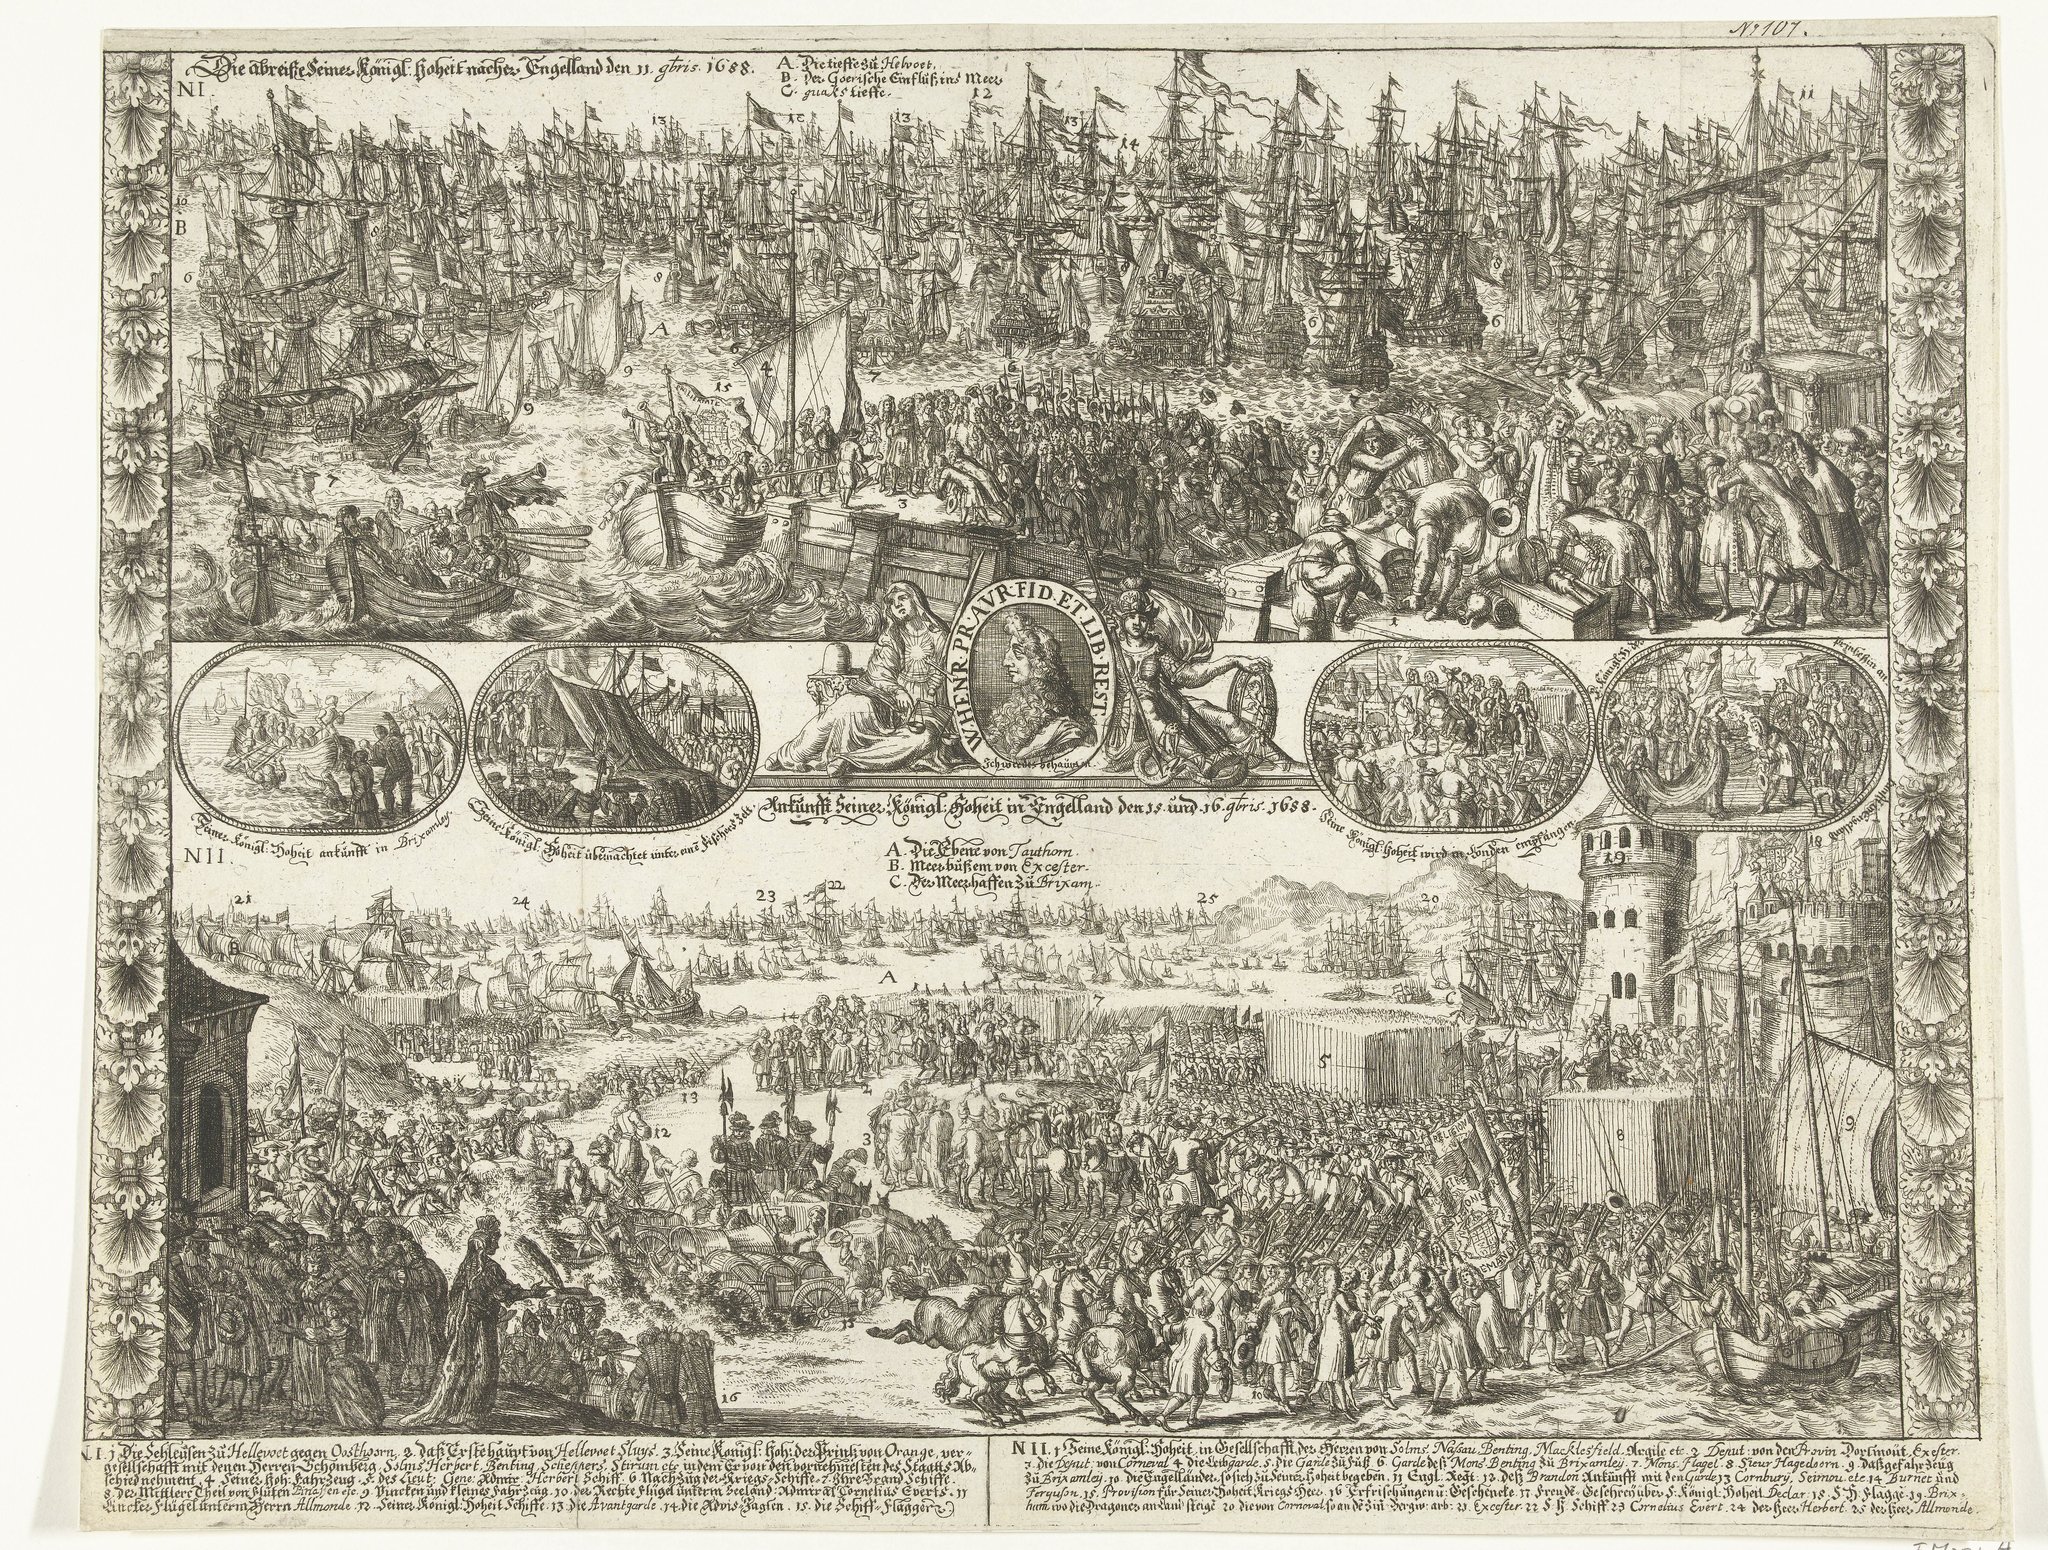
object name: print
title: Die abreisse Seiner Königl: Hoheit nacher Engelland den 11. [novem]bris 1688 / Ankunfft Seiner Königl: Hoheit in Engelland den 15. und 16. [novem]bris 1688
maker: Anonymous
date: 1688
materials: paper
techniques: etching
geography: northern netherlands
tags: the hague, william iii (prince of orange and king of england, scotland, and ireland), arrival and return ~ travelling, departure ~ travelling, hellevoetsluis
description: Tocht van Willem III naar Engeland, 1688. Twee voorstellingen, genummerd I en II. Boven: het vertek van Willem met zijn vloot op 11 november 1688 vanuit Hellevoetsluis. Volle kade en overzicht van de schepen. Onder de aankomst van de vloot van de prins in Torbay bij Brixham, 15 en 16 november 1688. Op de voorgrond gaat de prins aan land. Onderaan de verklaringen van de cijfers 1-15 en 1-25 in het Duits. In het midden een portret van de prins in profiel naar links met Rechtvaardigheid en Nederlandse Maagd. Hierbij vier ovale cartouches met kleine scènes van gebeurtenissen na de aankomst in Engeland.